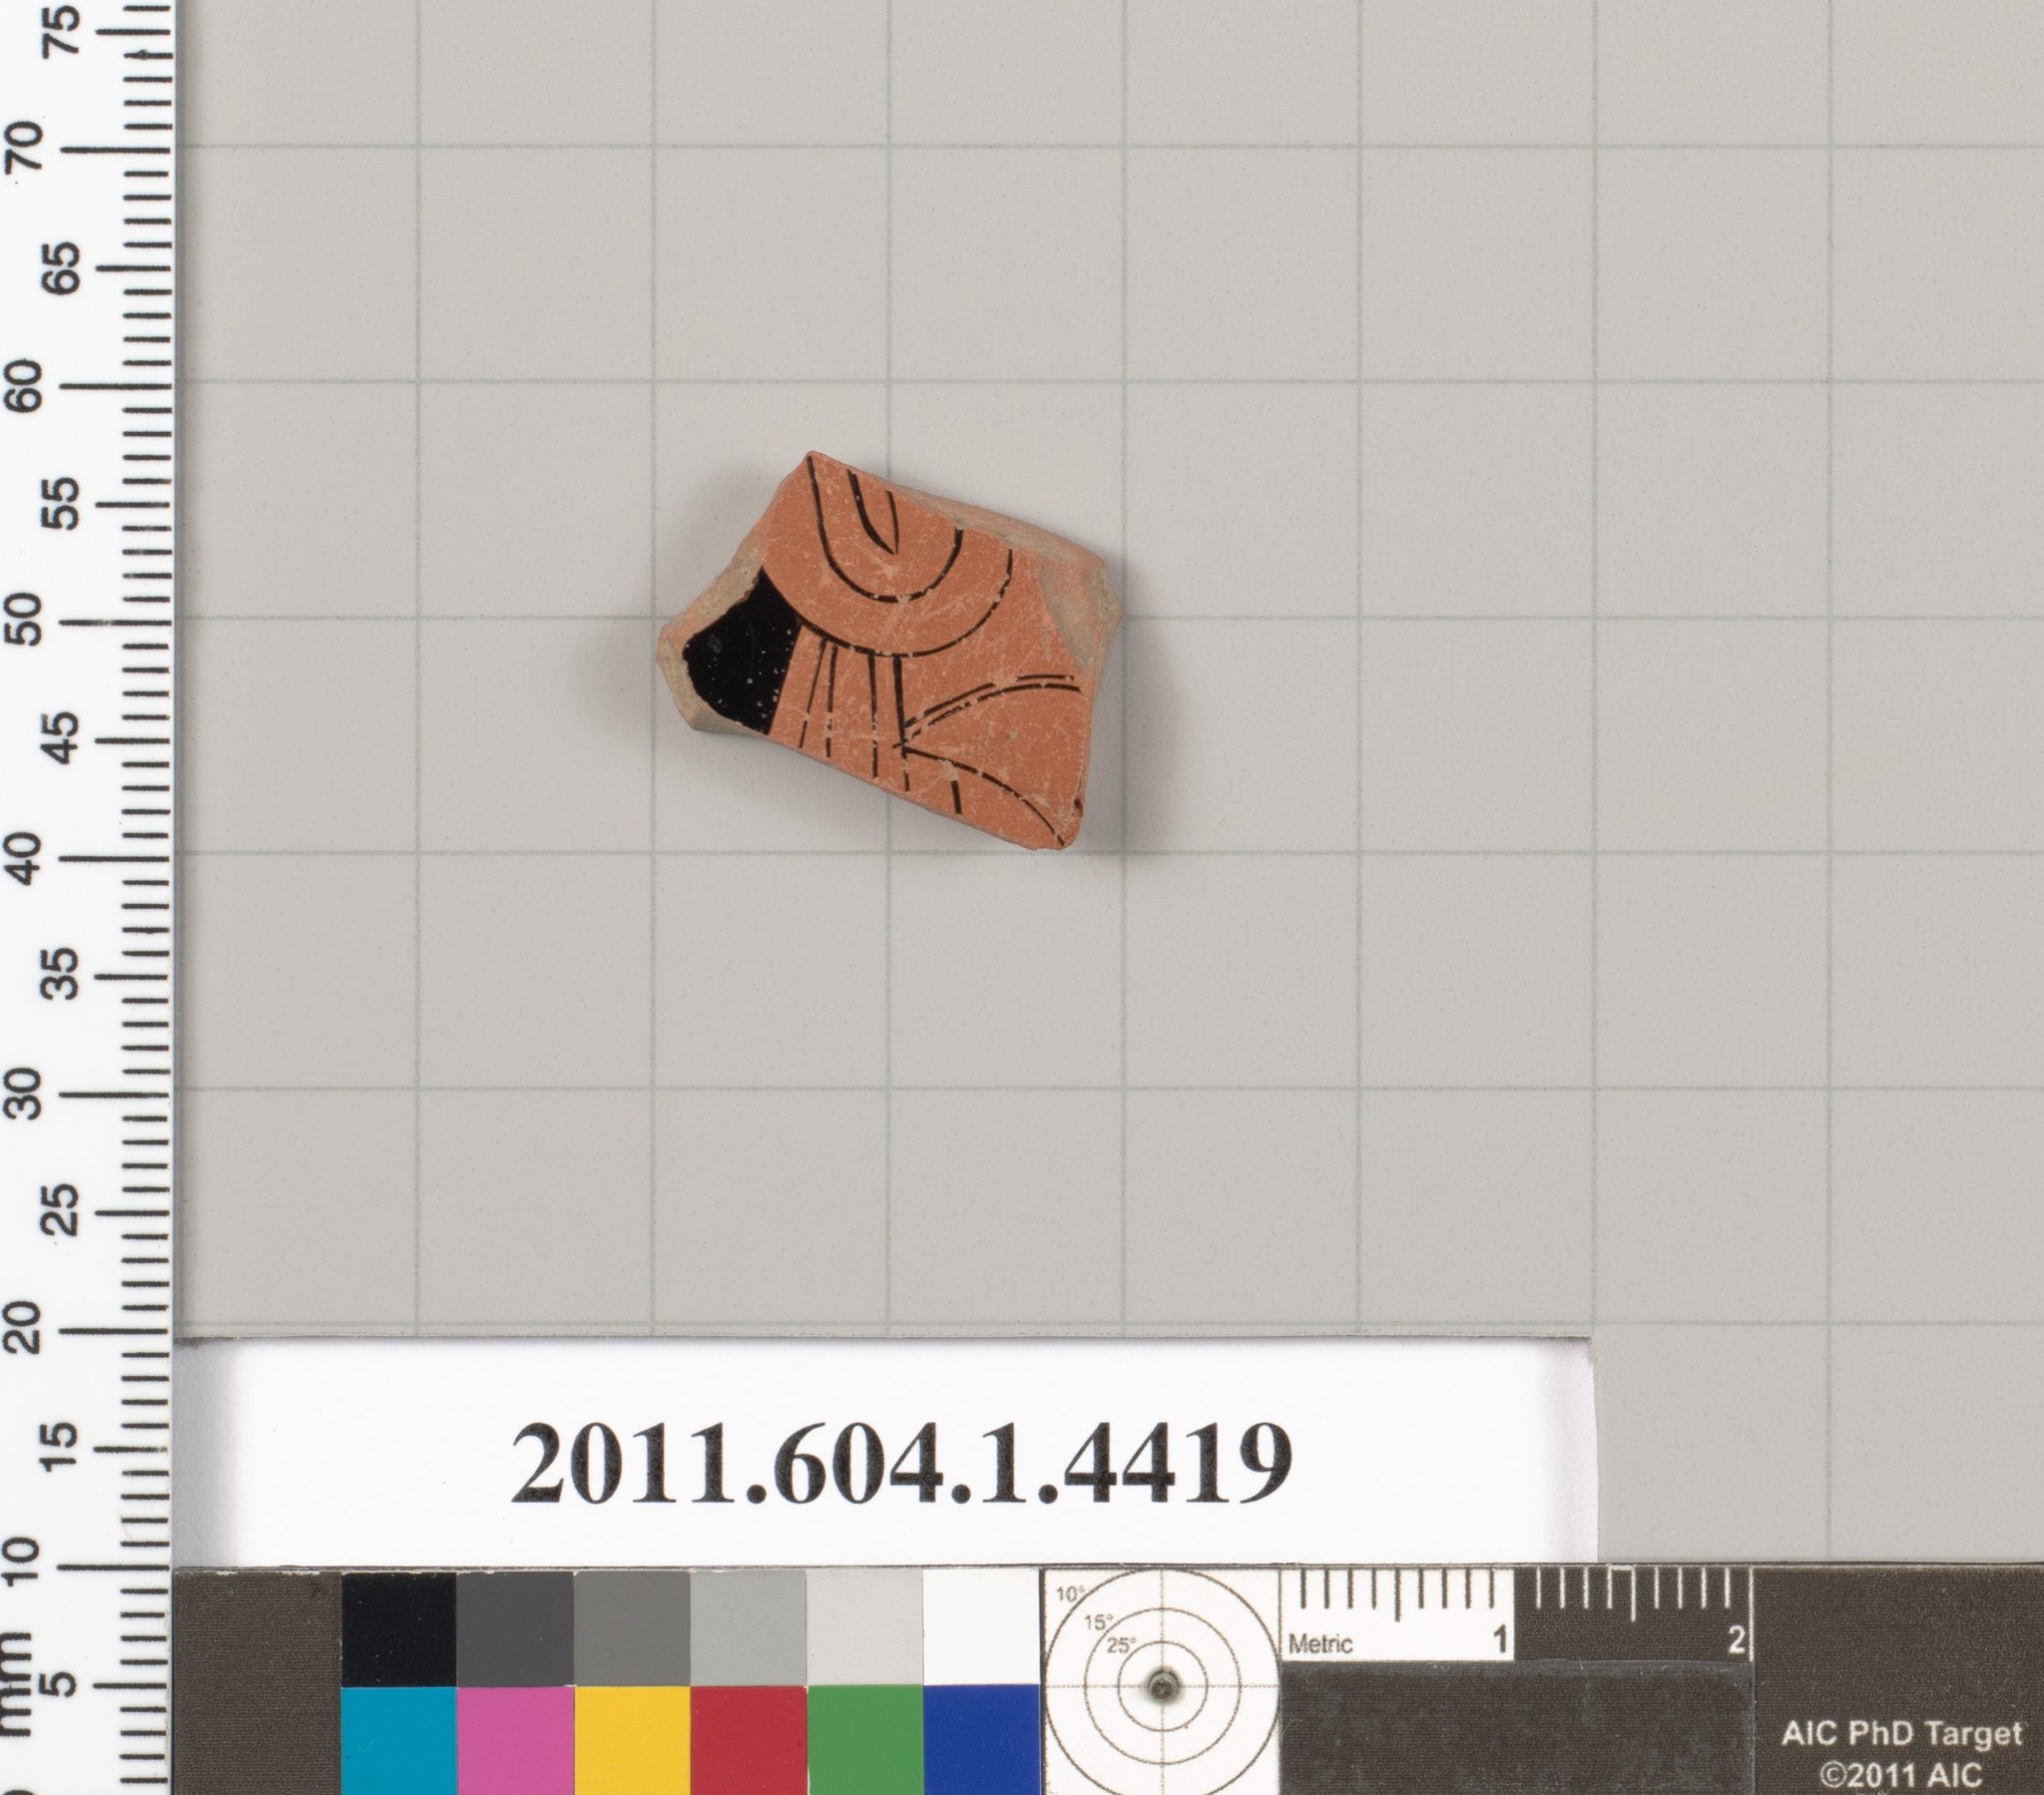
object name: kylix fragment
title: Terracotta fragment of a kylix (drinking cup)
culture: greek, attic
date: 490-470 BCE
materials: terracotta